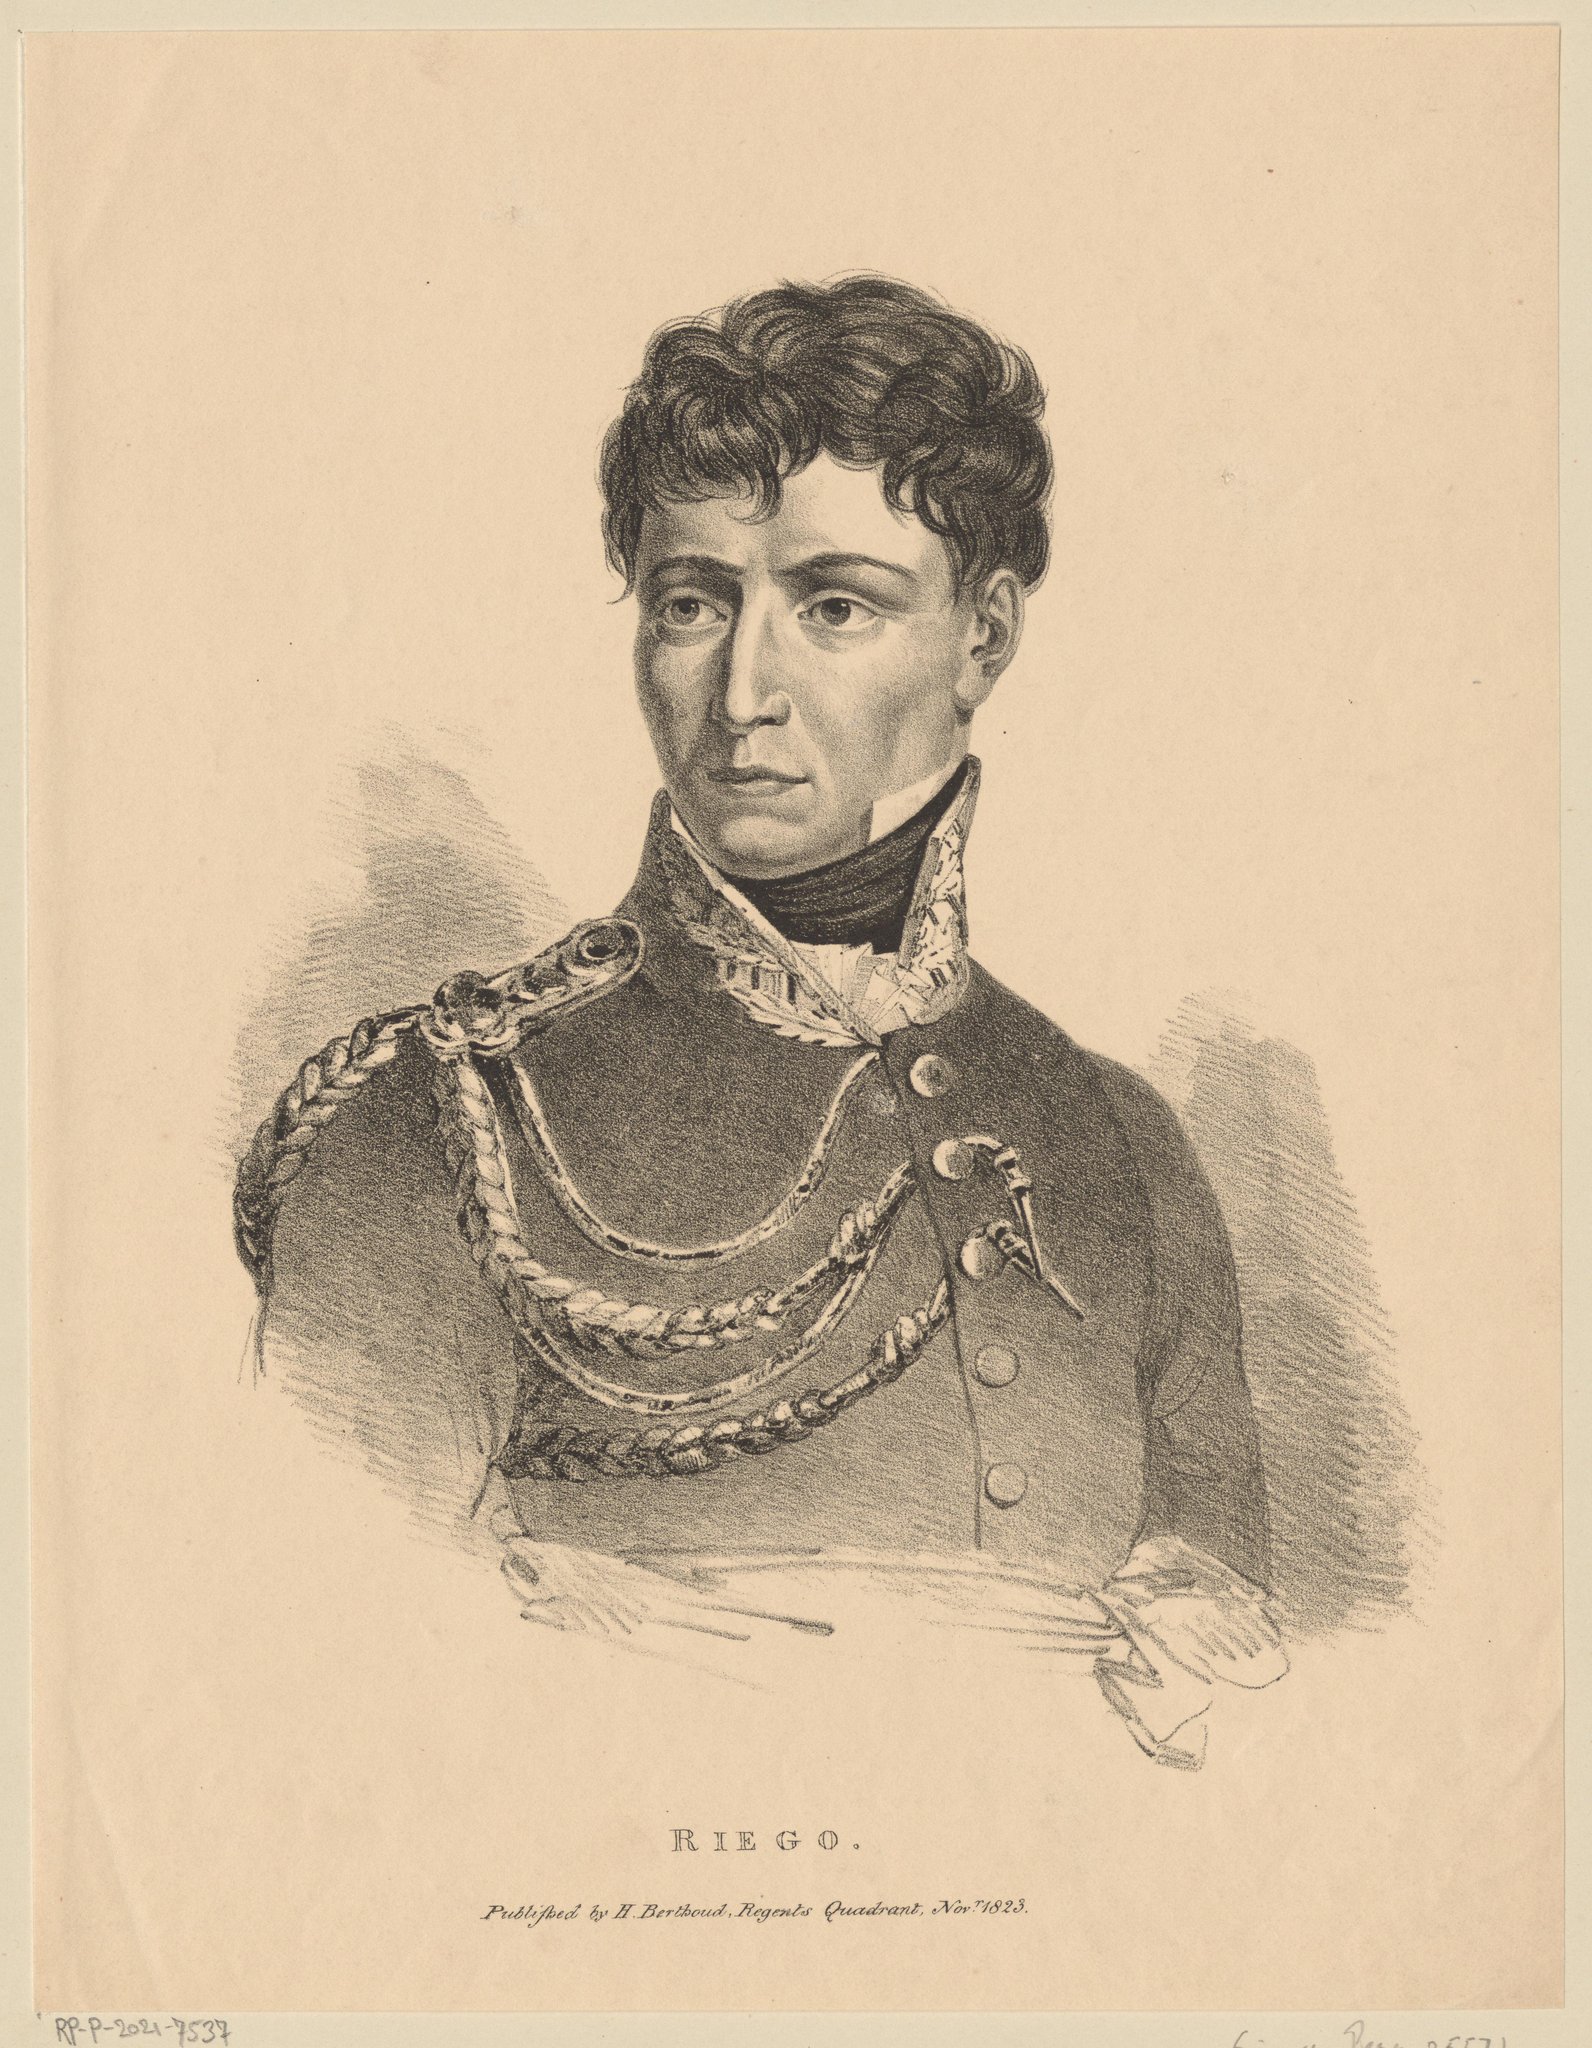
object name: print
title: Portret van Rafael del Riego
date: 1811-1823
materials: paper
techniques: lithograph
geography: london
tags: politician, historical persons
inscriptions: date